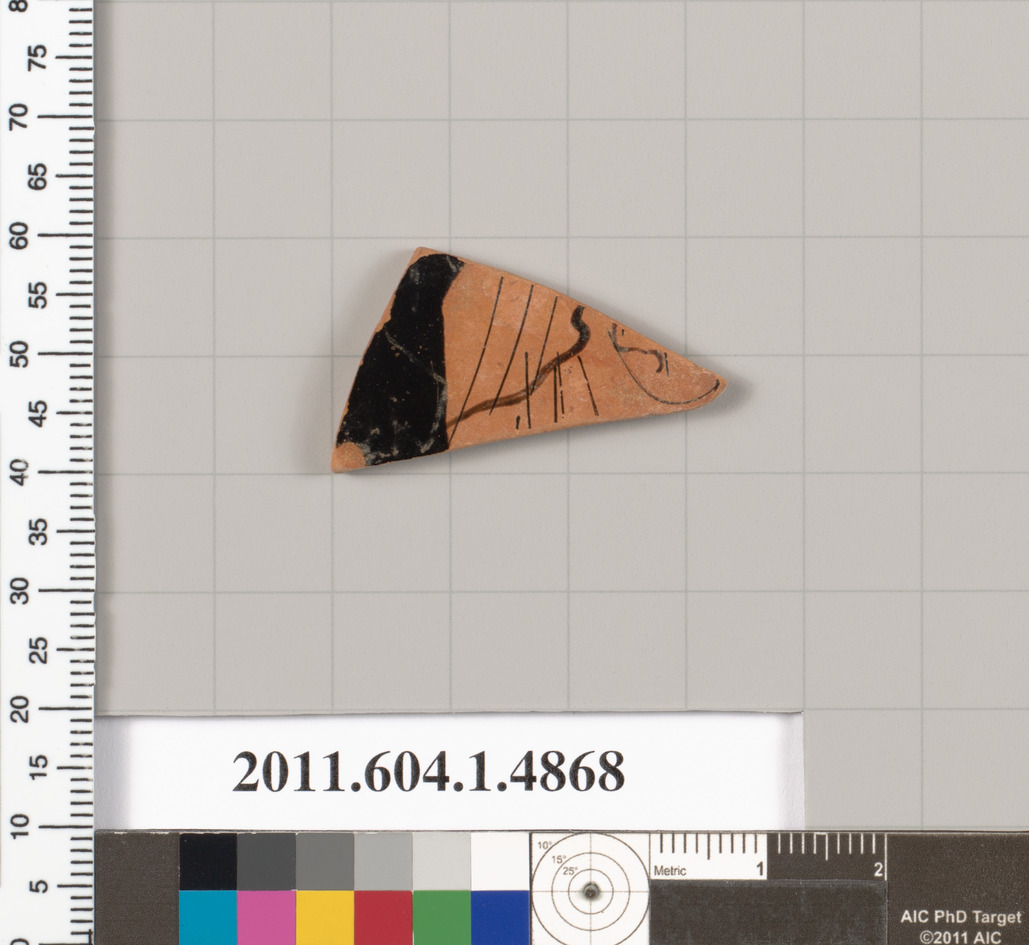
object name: kylix fragment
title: Terracotta fragment of a kylix (drinking cup)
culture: greek, attic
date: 475-451 BCE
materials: terracotta